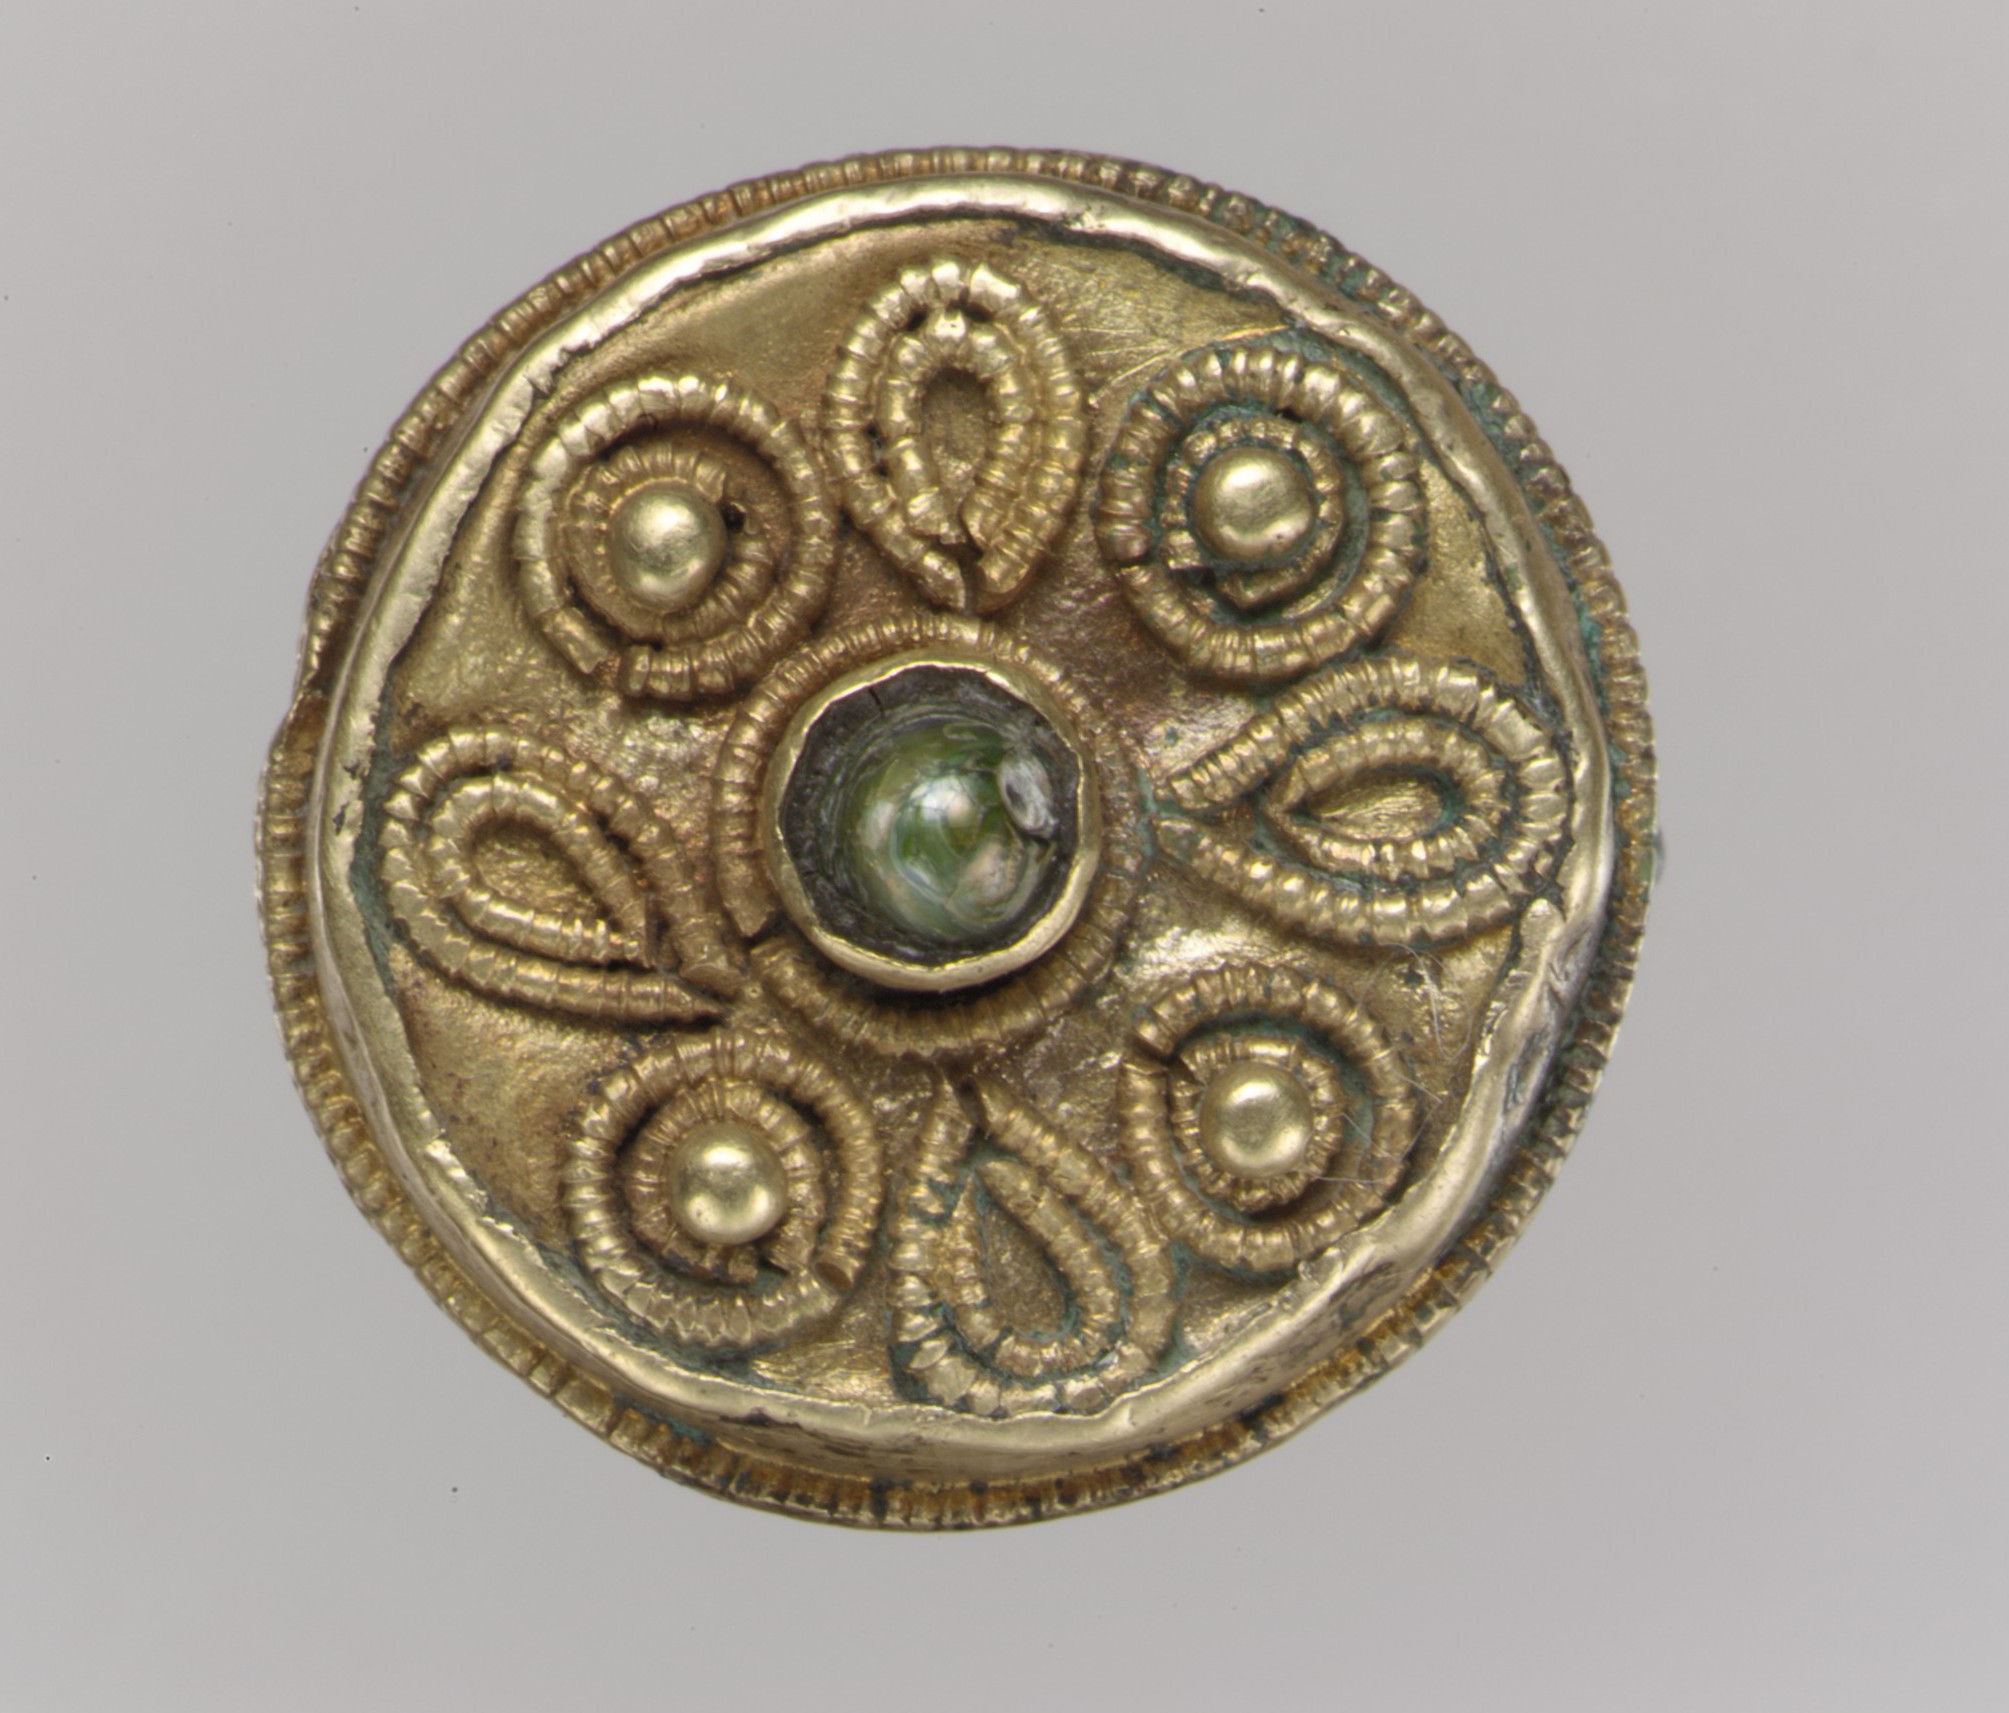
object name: brooch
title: Disk Brooch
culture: frankish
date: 601-700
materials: gold, paste, metal